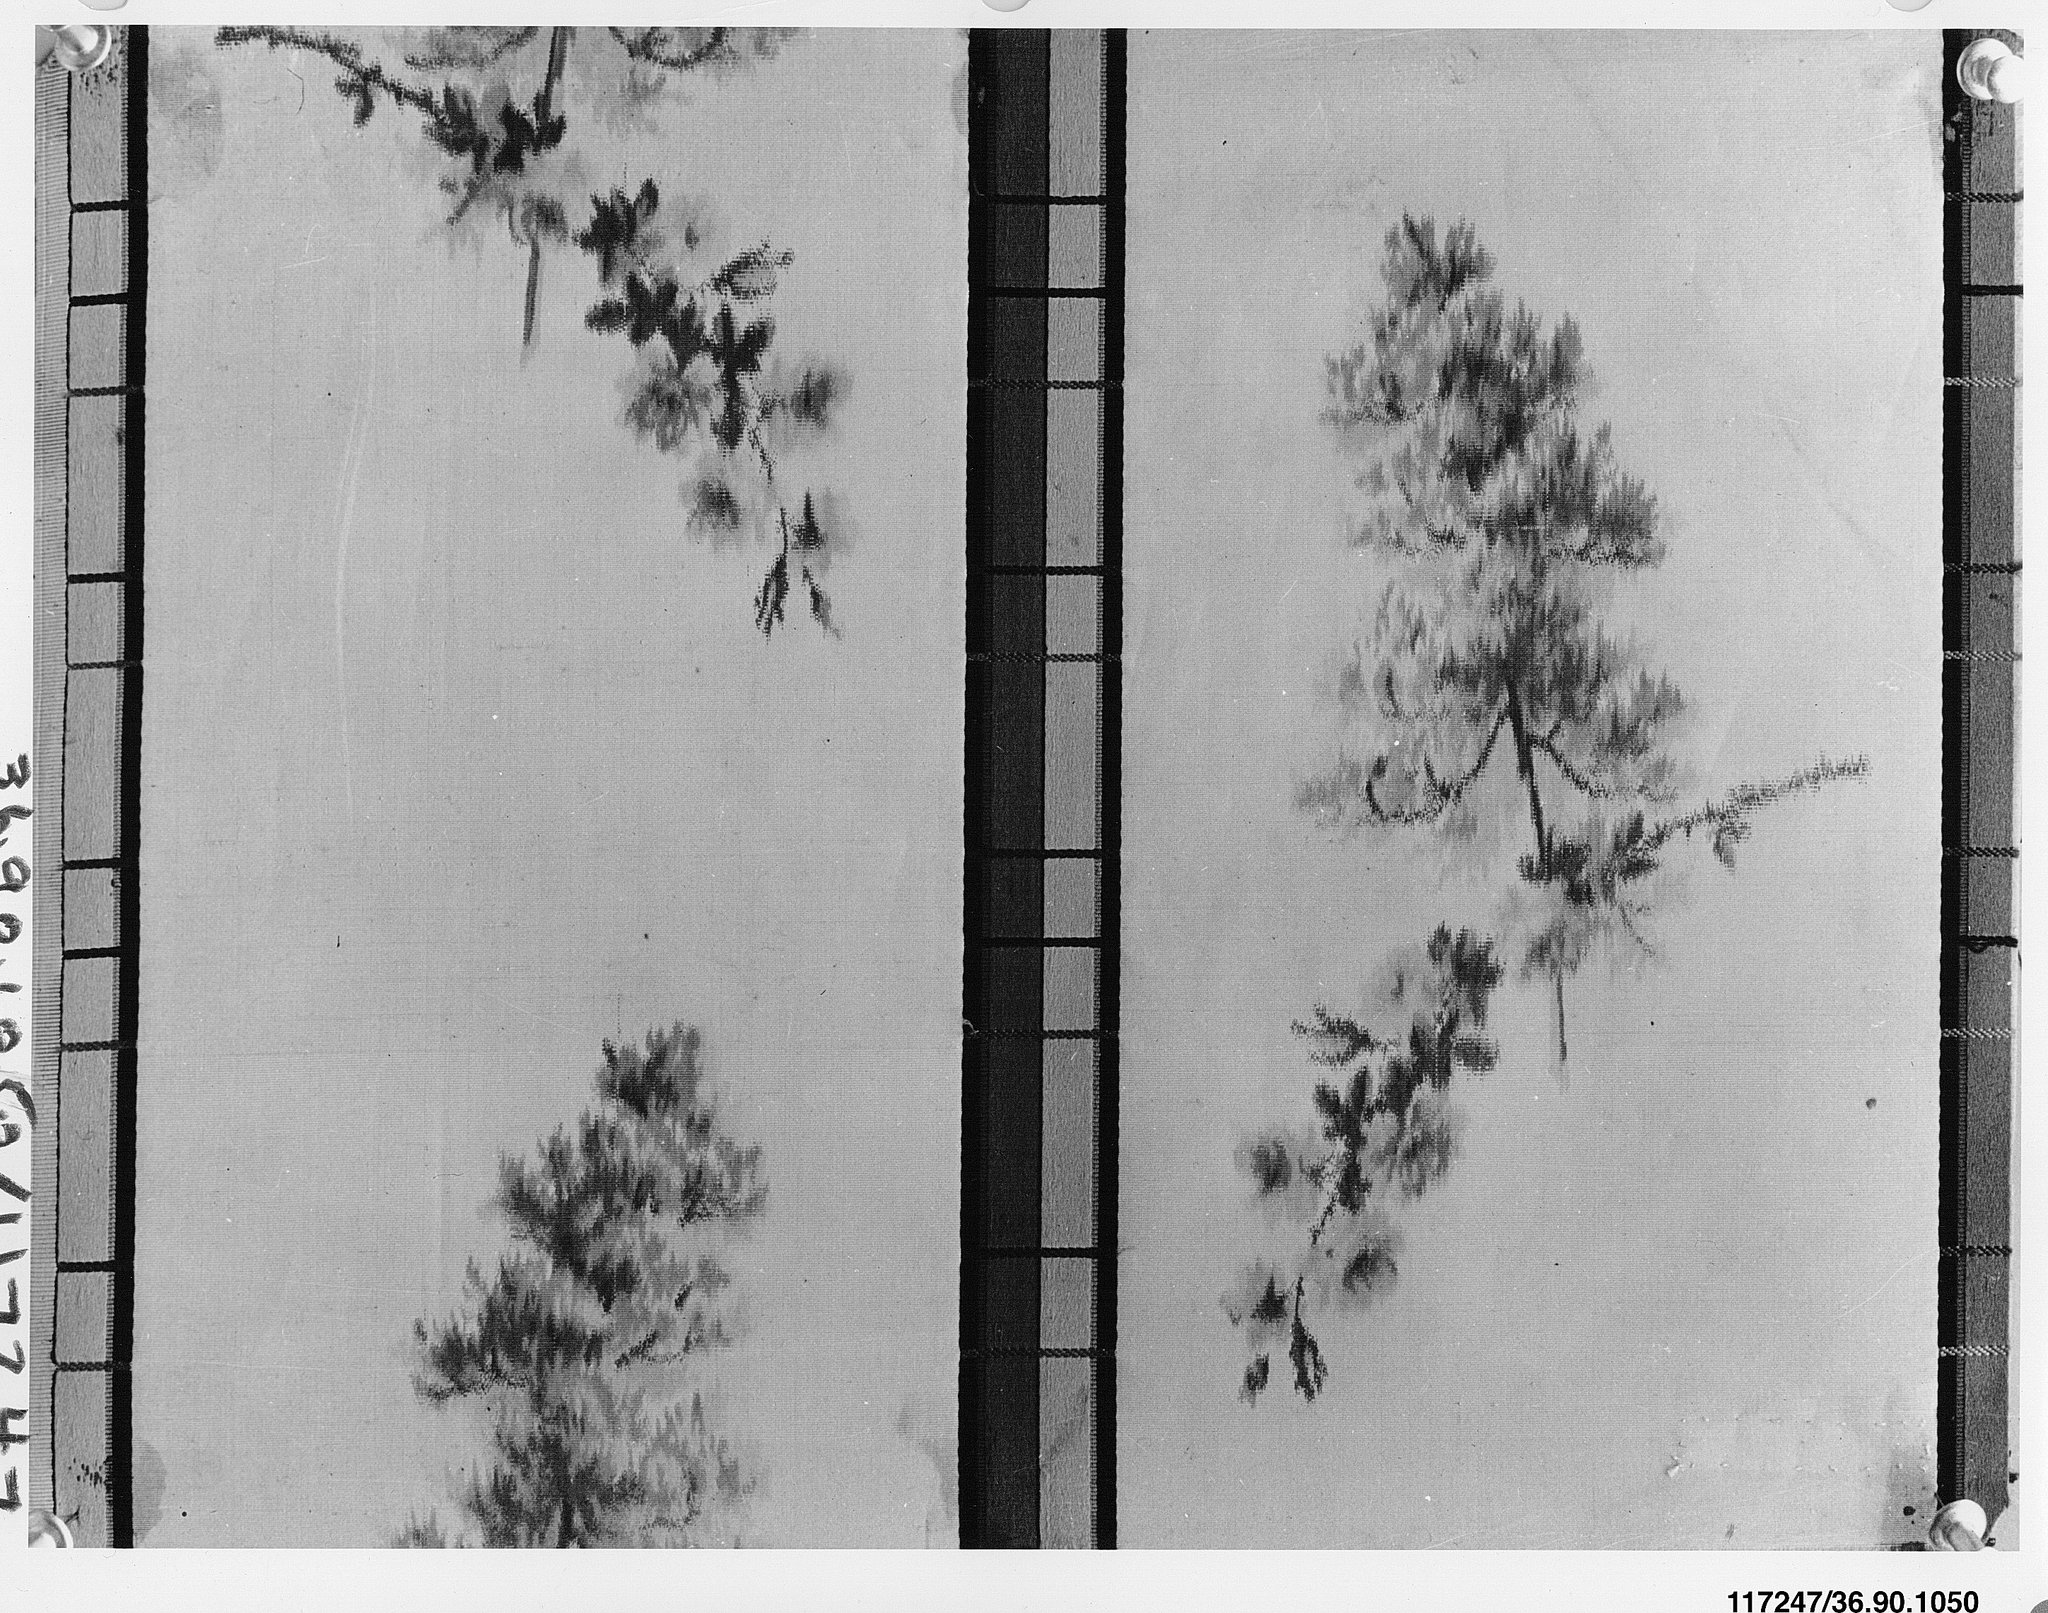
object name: piece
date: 1867-1900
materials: silk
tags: flowers,leaves